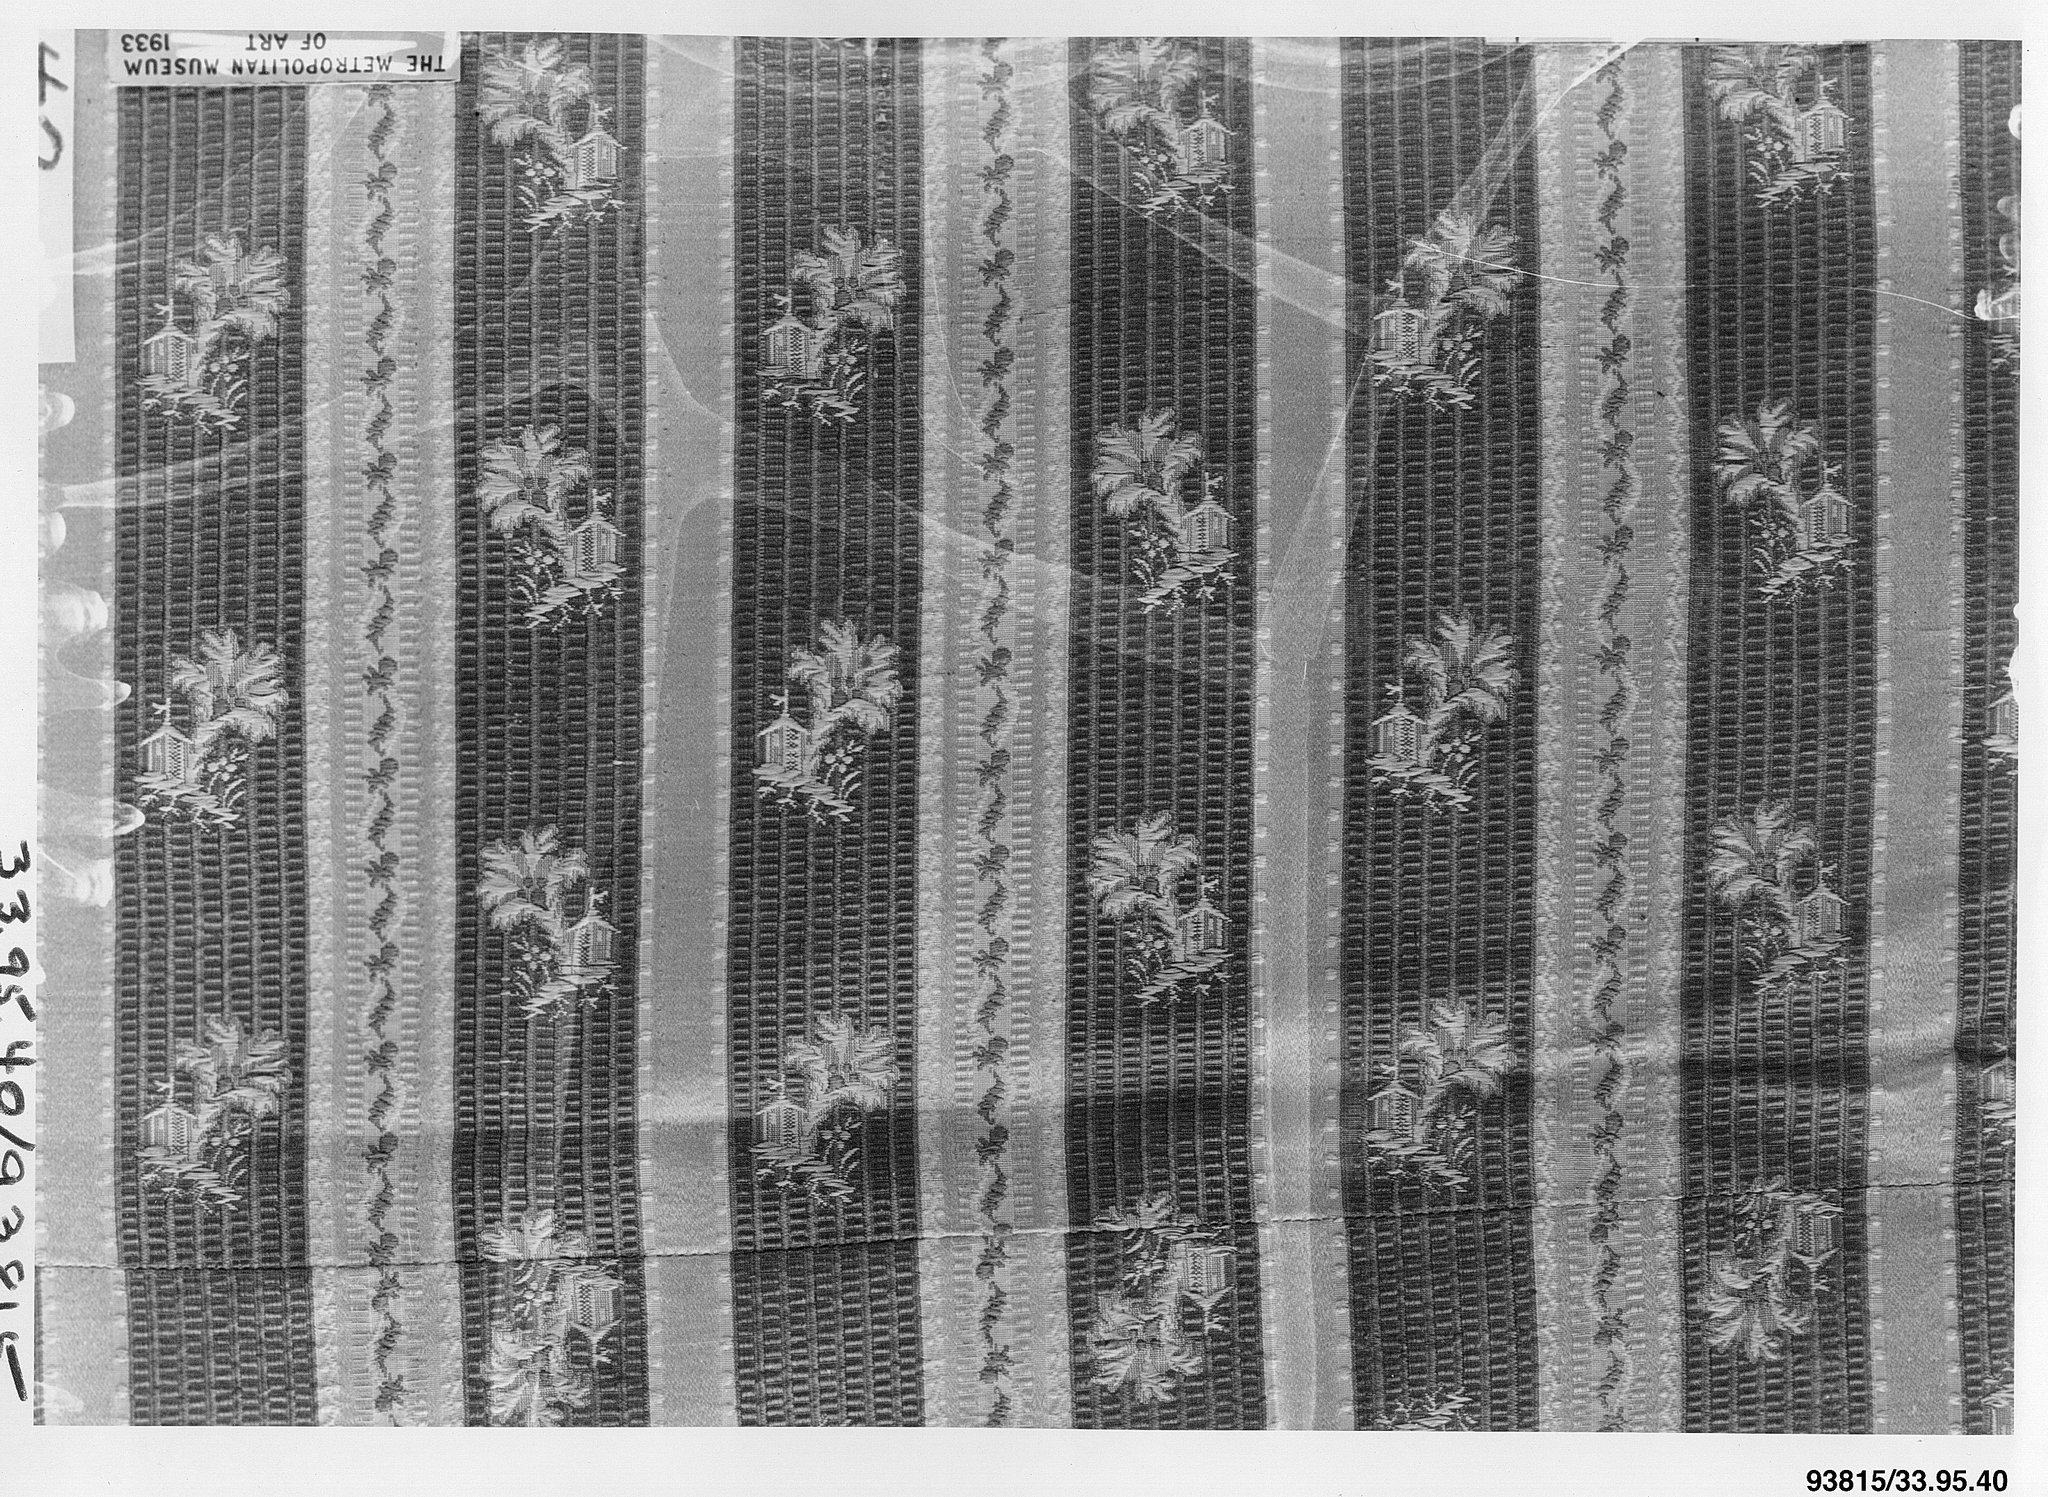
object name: piece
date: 1775-1790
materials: silk